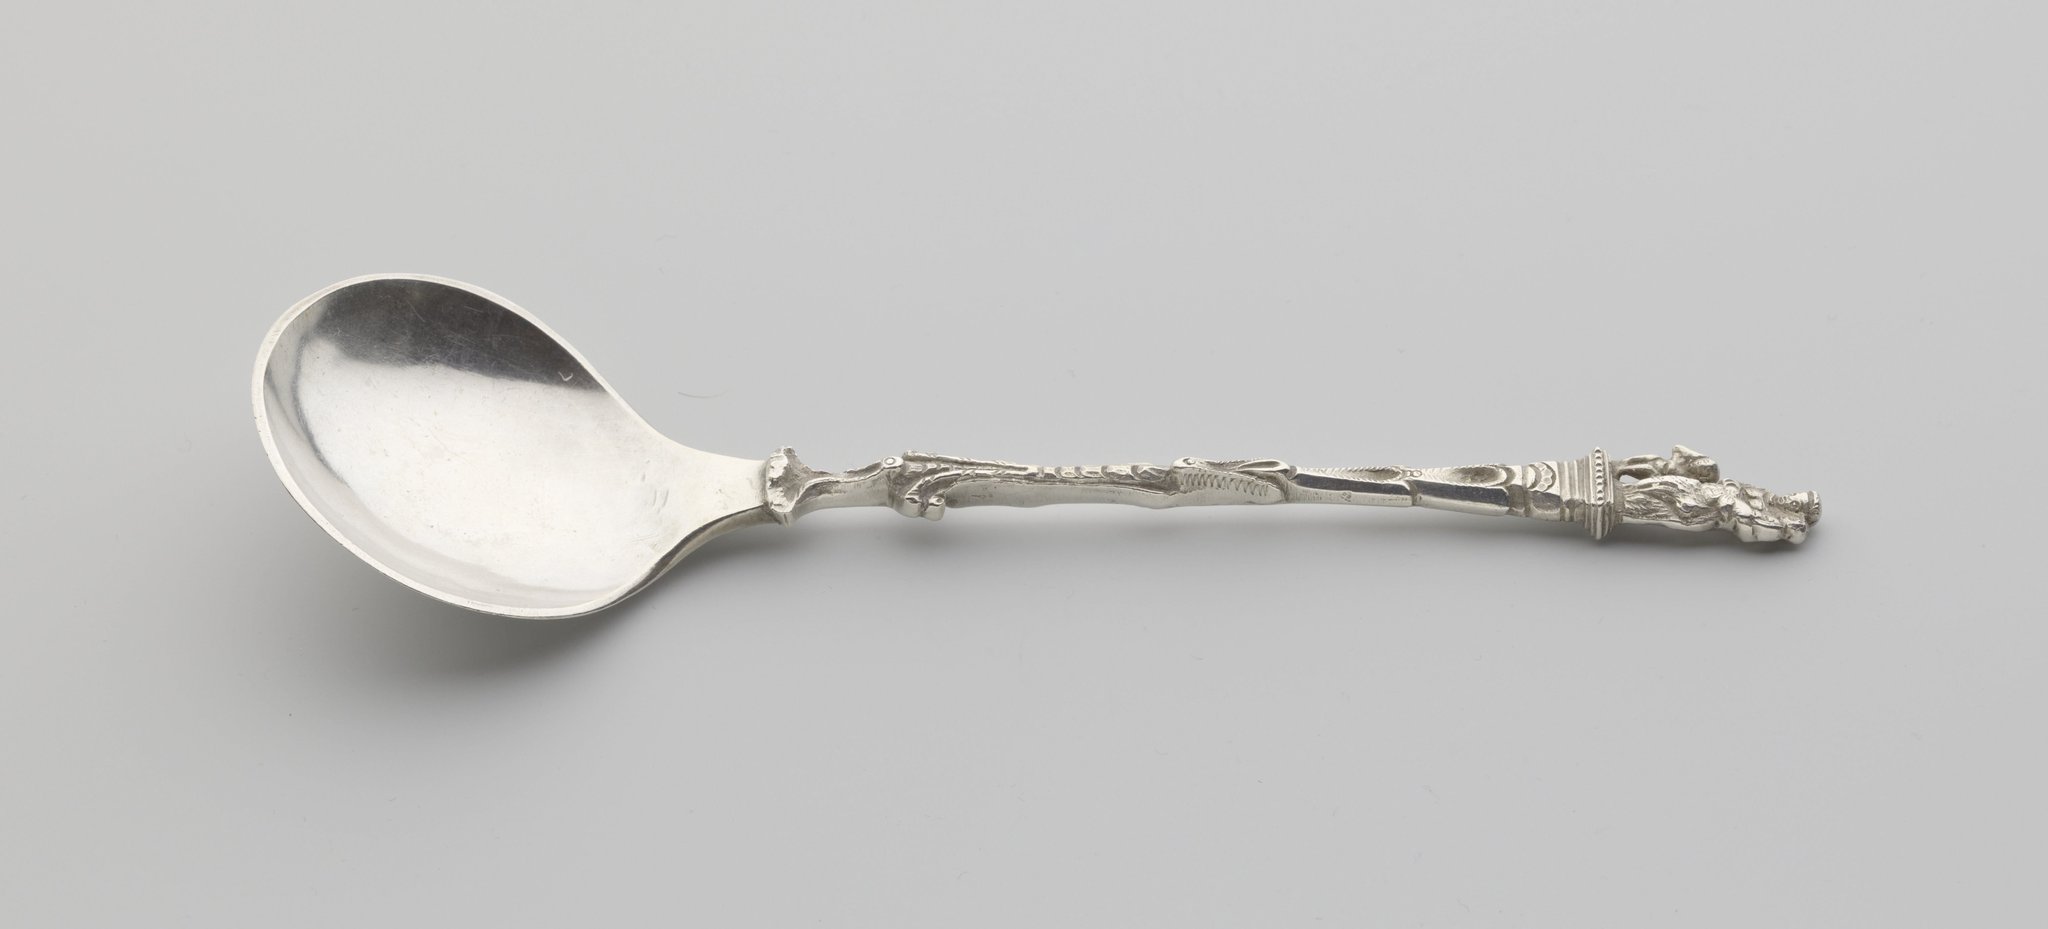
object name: forgery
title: Lepel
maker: Anonymous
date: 1400-1950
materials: silver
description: Zilveren lepel. De steel wordt bekroond door een vrouw met een kind op de arm en een kind aan de hand, voorstellende de moederlijke liefde. Merken op de achterzijde van de bak de jaarletter T en andere merken. Behoort bij inv. nr. BK-NM-2942.